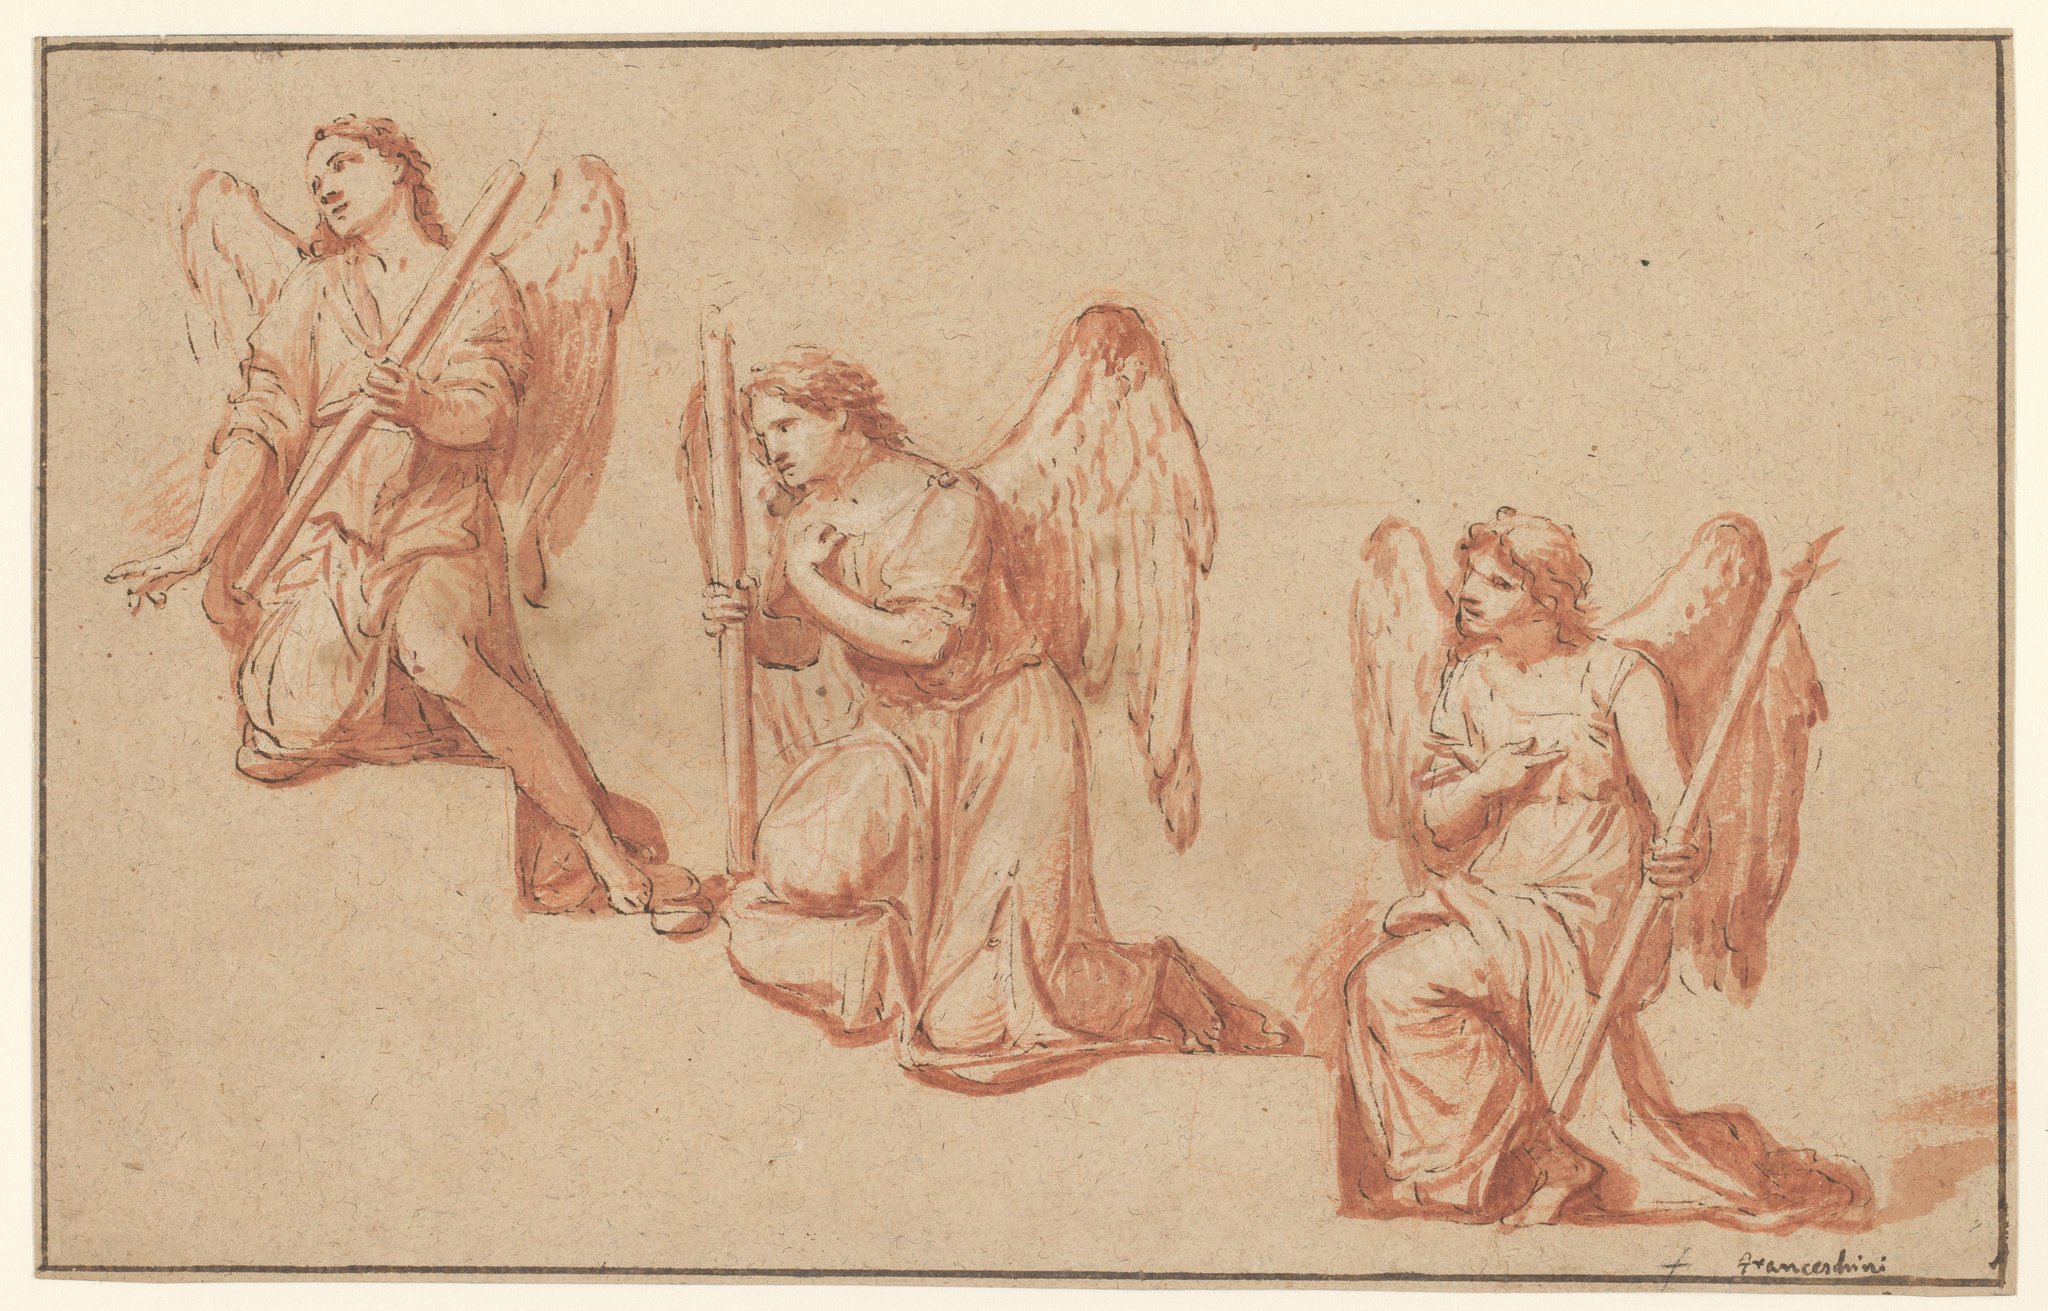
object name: drawing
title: Drie studies van knielende engelen met een toorts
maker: marco antonio franceschini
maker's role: draughtsman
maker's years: 1648-1729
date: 1690-1699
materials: paint, paper, watercolor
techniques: brush, pen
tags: angels